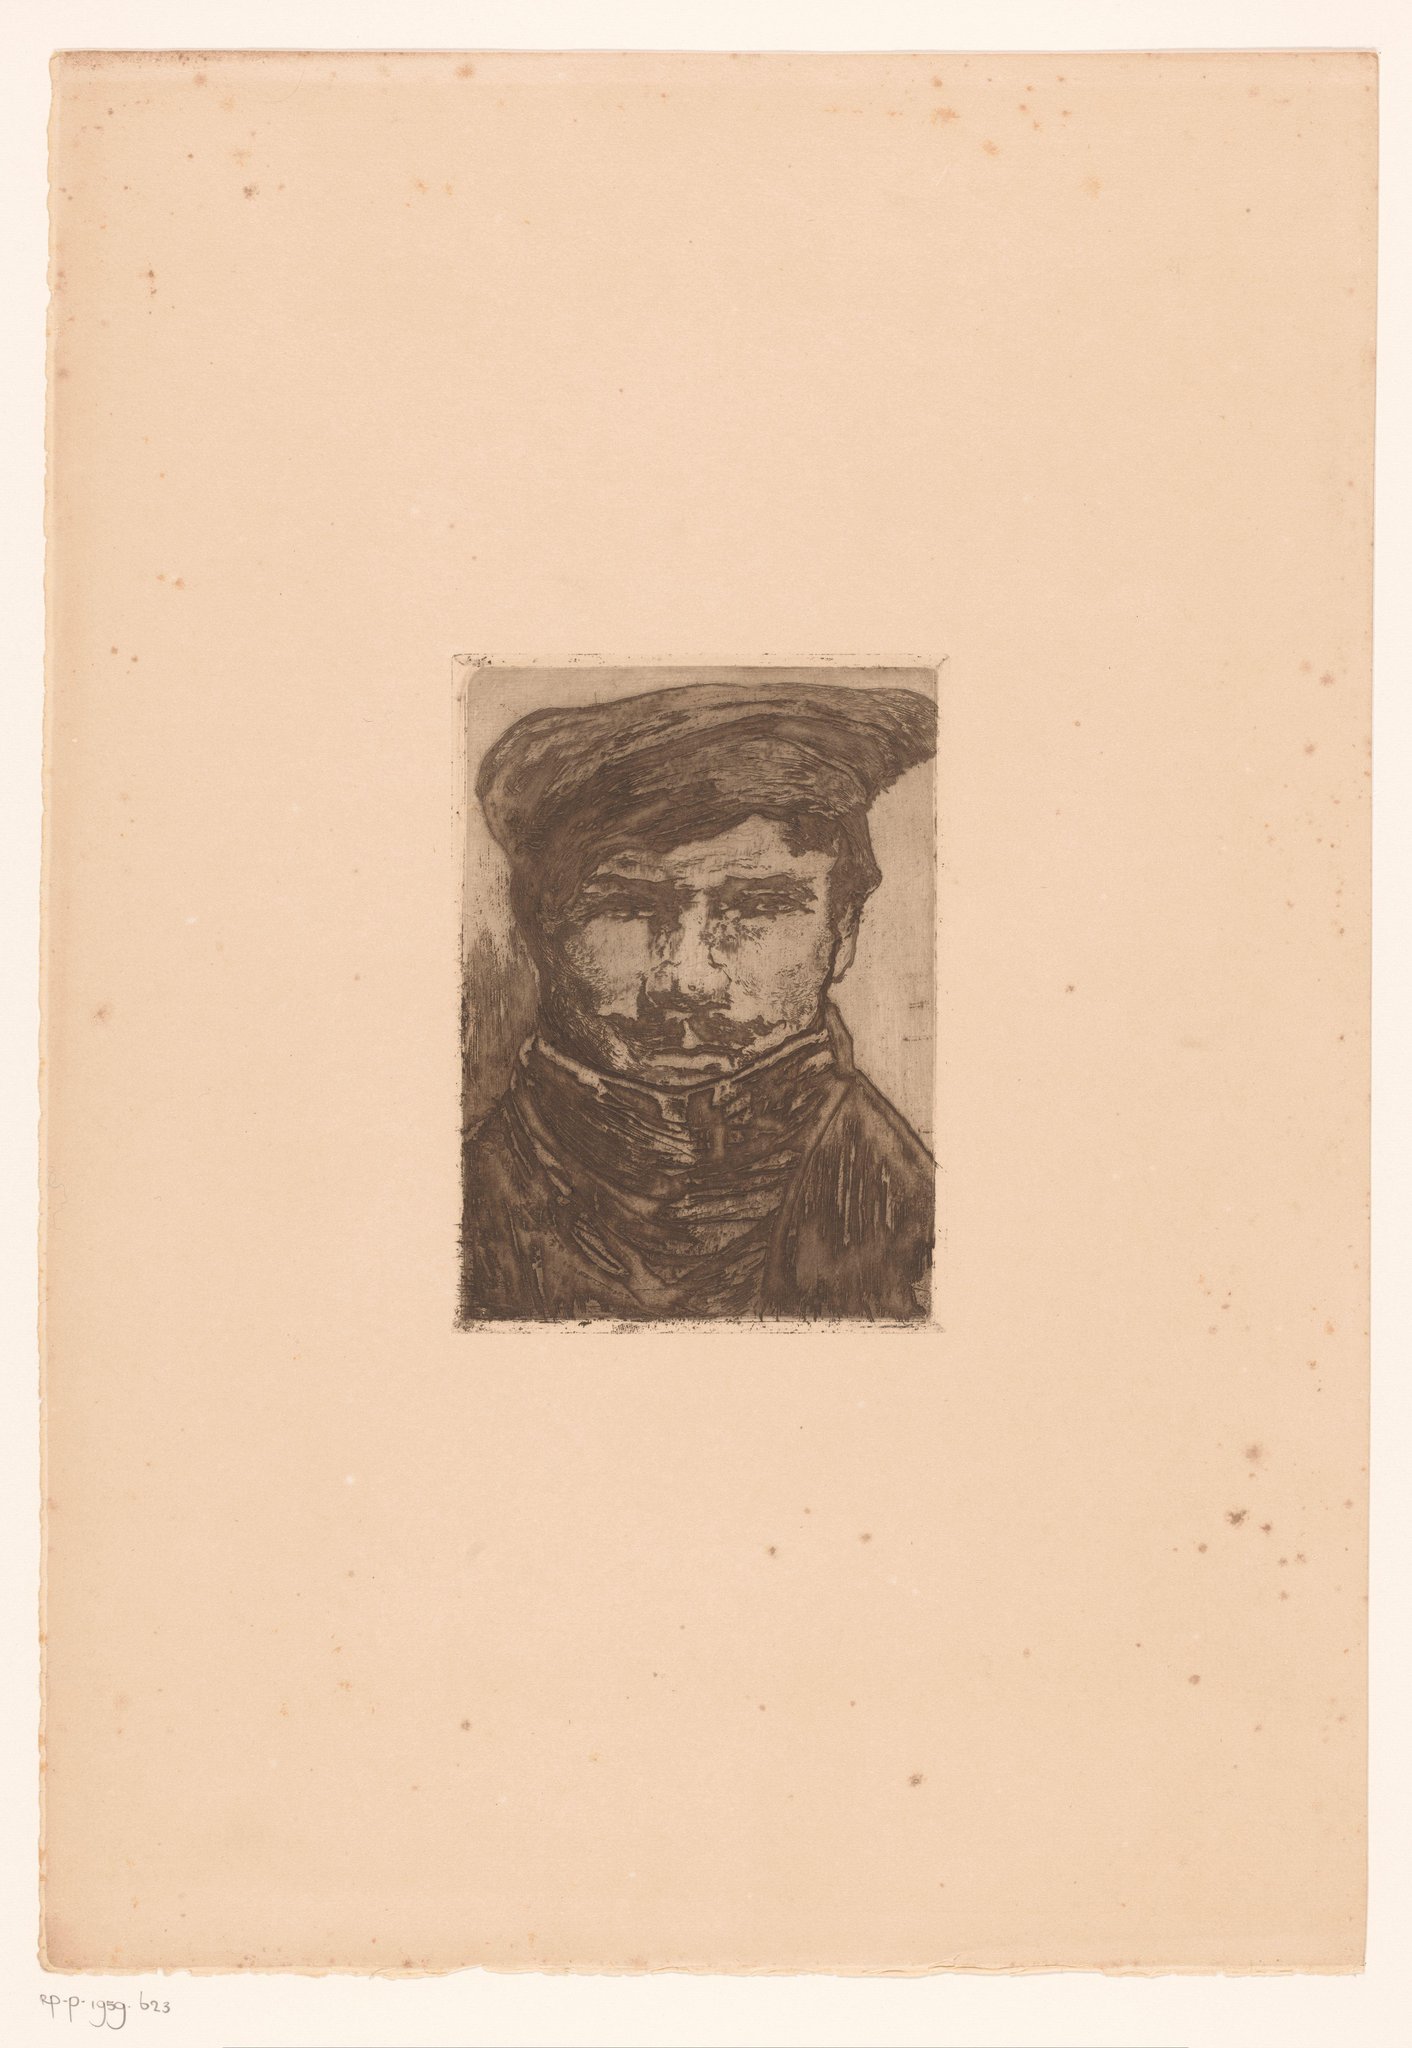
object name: print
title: Portret van een onbekende man met pet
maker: alfred napoléon delaunois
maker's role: print maker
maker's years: 1876-1941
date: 1886-1941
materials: paper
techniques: aquatint, etching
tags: anonymous historical person portrayed alone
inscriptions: collector's mark: Lugt 2228, collector's mark: Lugt 2760